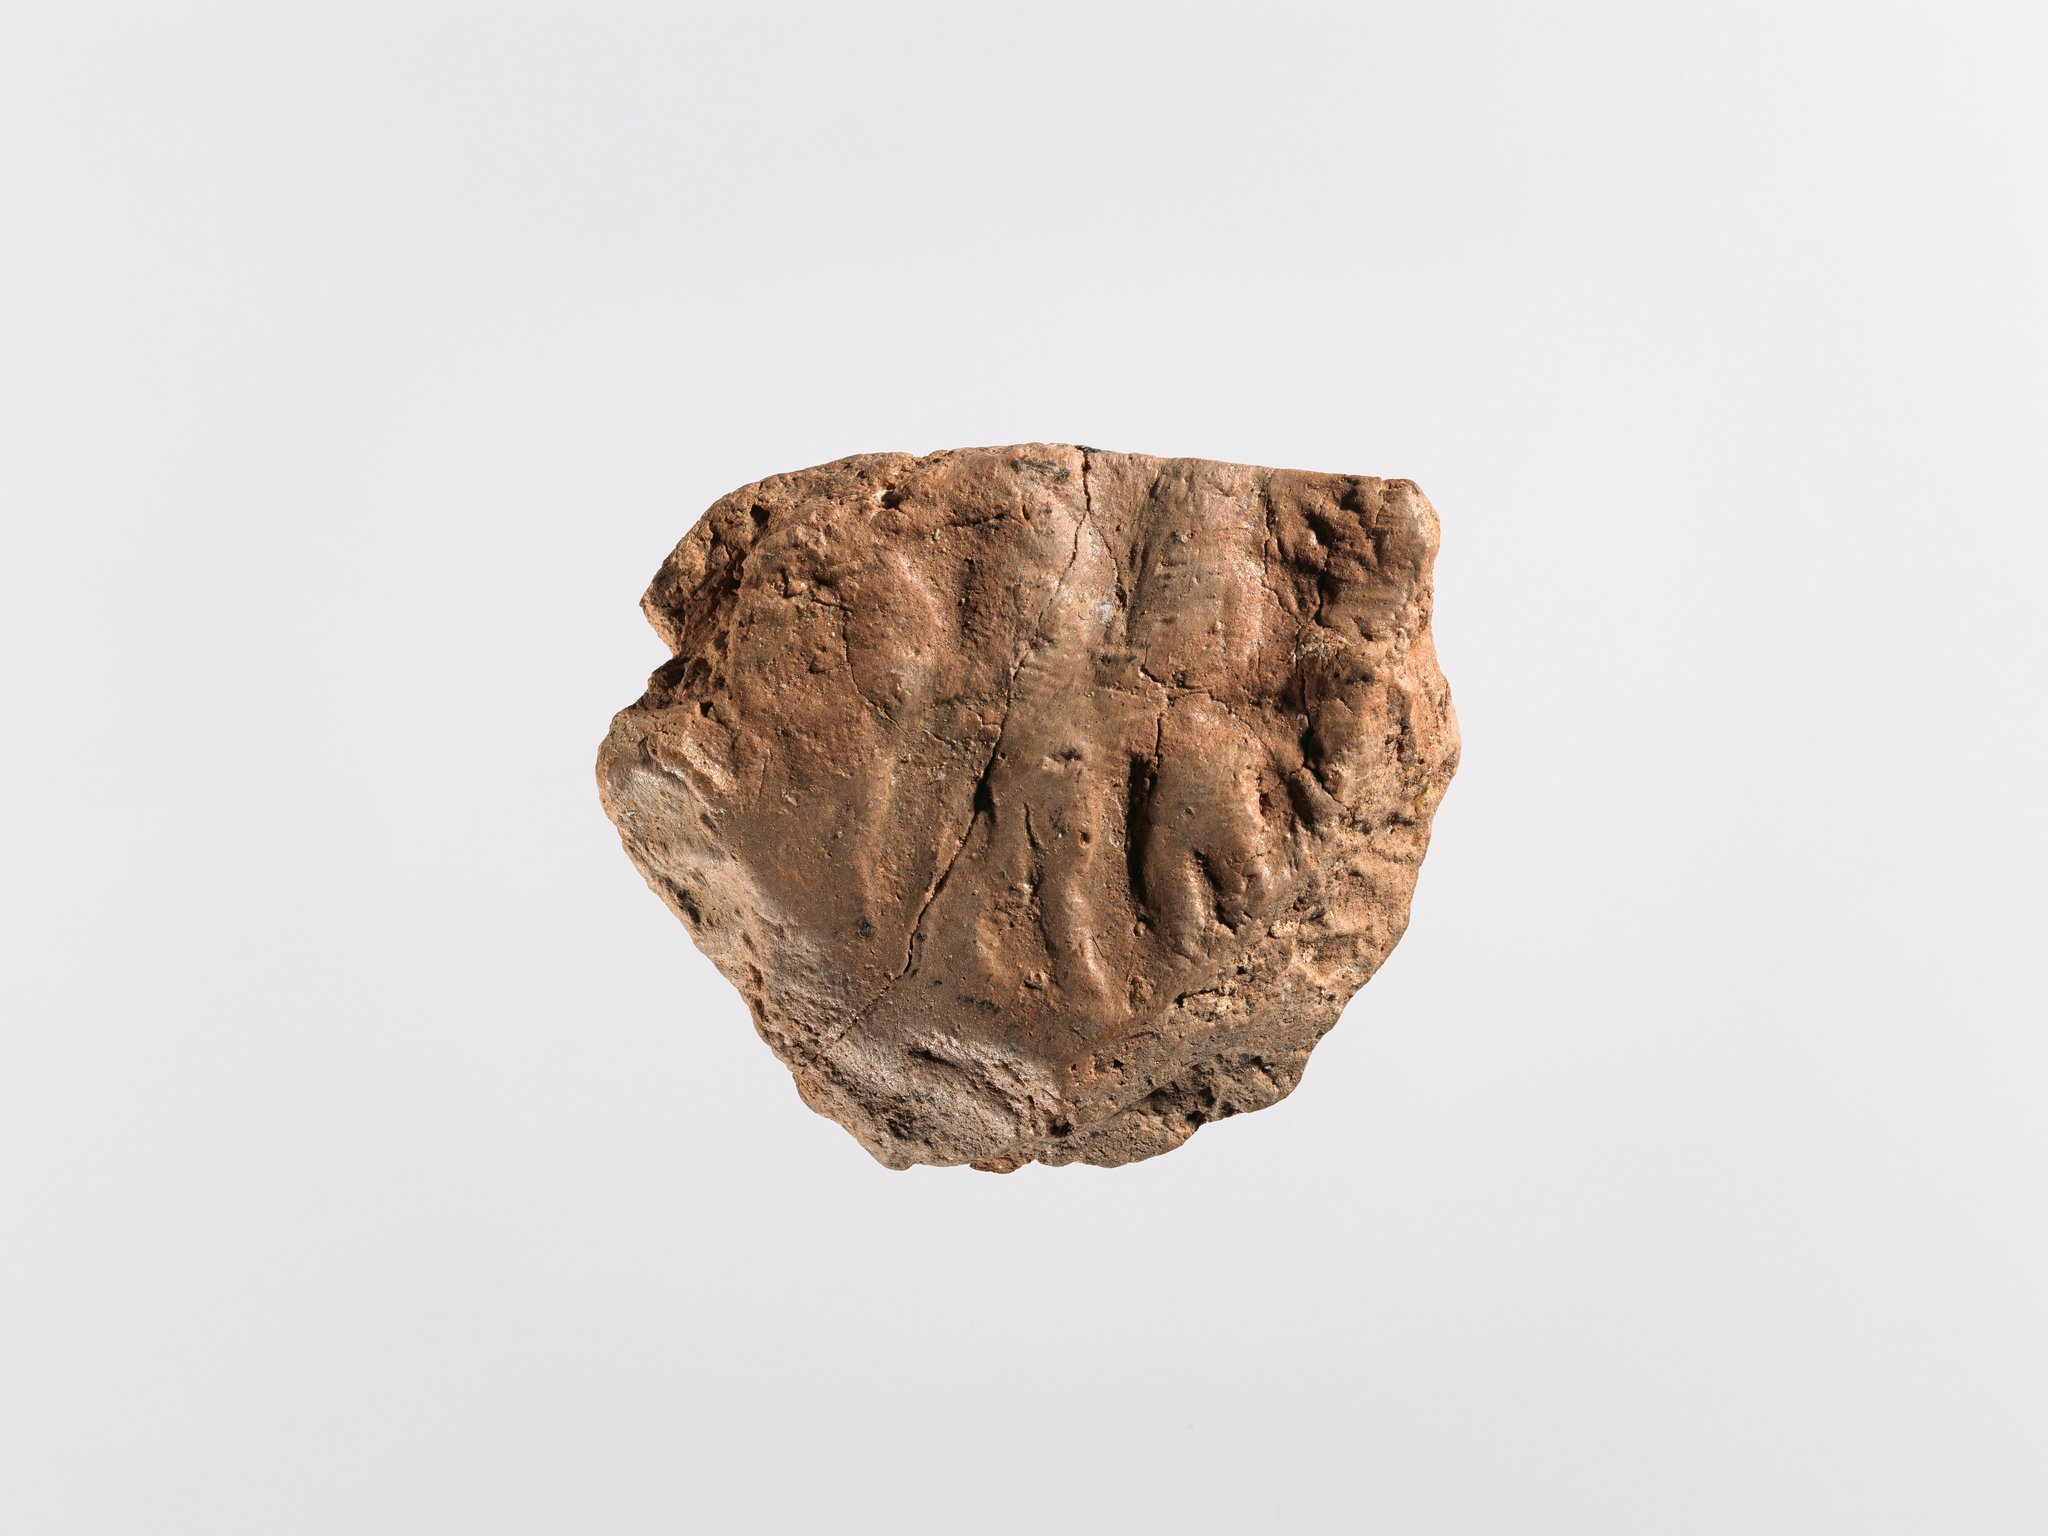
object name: sealing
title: Sealing with cylinder seal impressions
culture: sumerian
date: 2700-2600 BCE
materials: clay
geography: mesopotamia